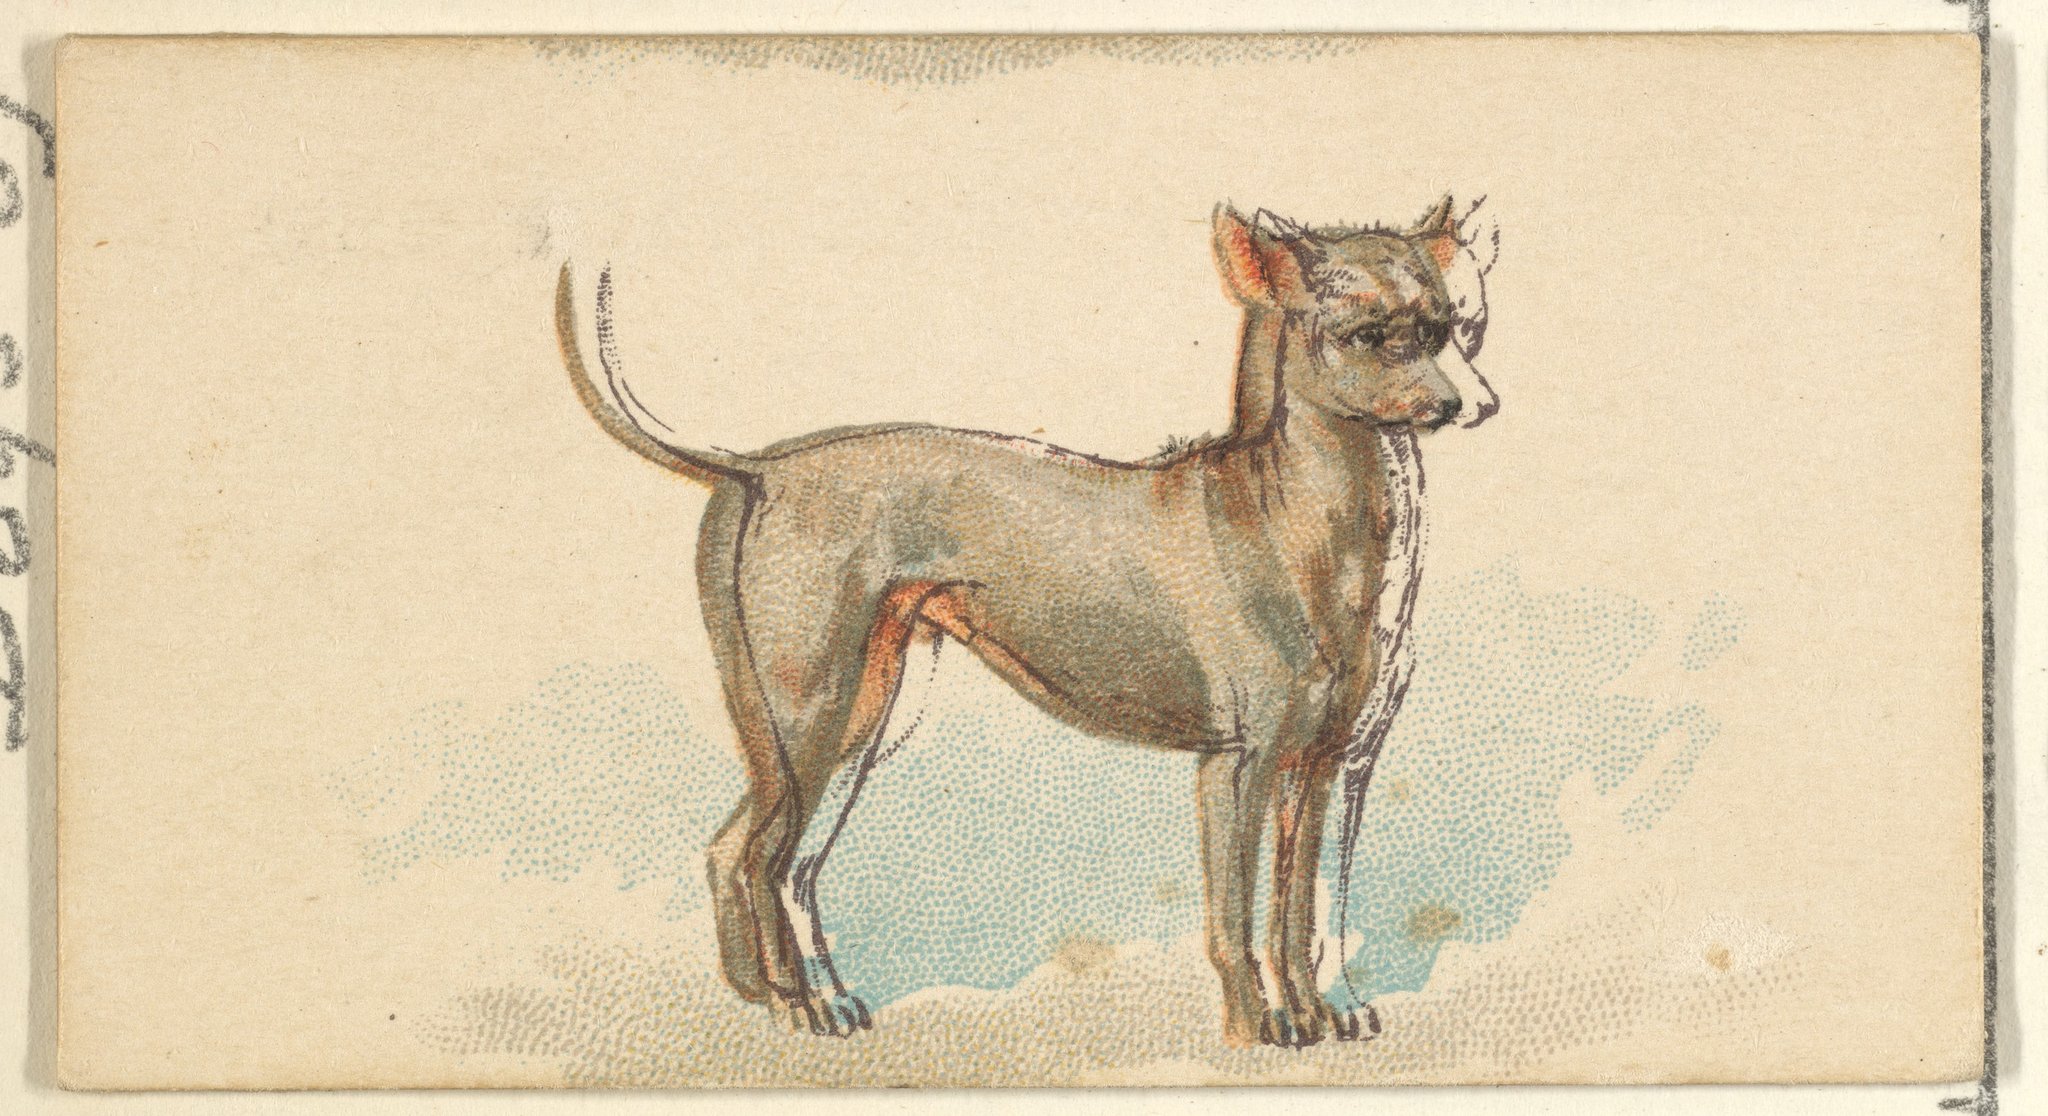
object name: print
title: Mexican Hairless, from the Dogs of the World series for Old Judge Cigarettes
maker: goodwin & company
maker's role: publisher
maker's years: 1850-1950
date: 1890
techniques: color lithograph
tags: dogs